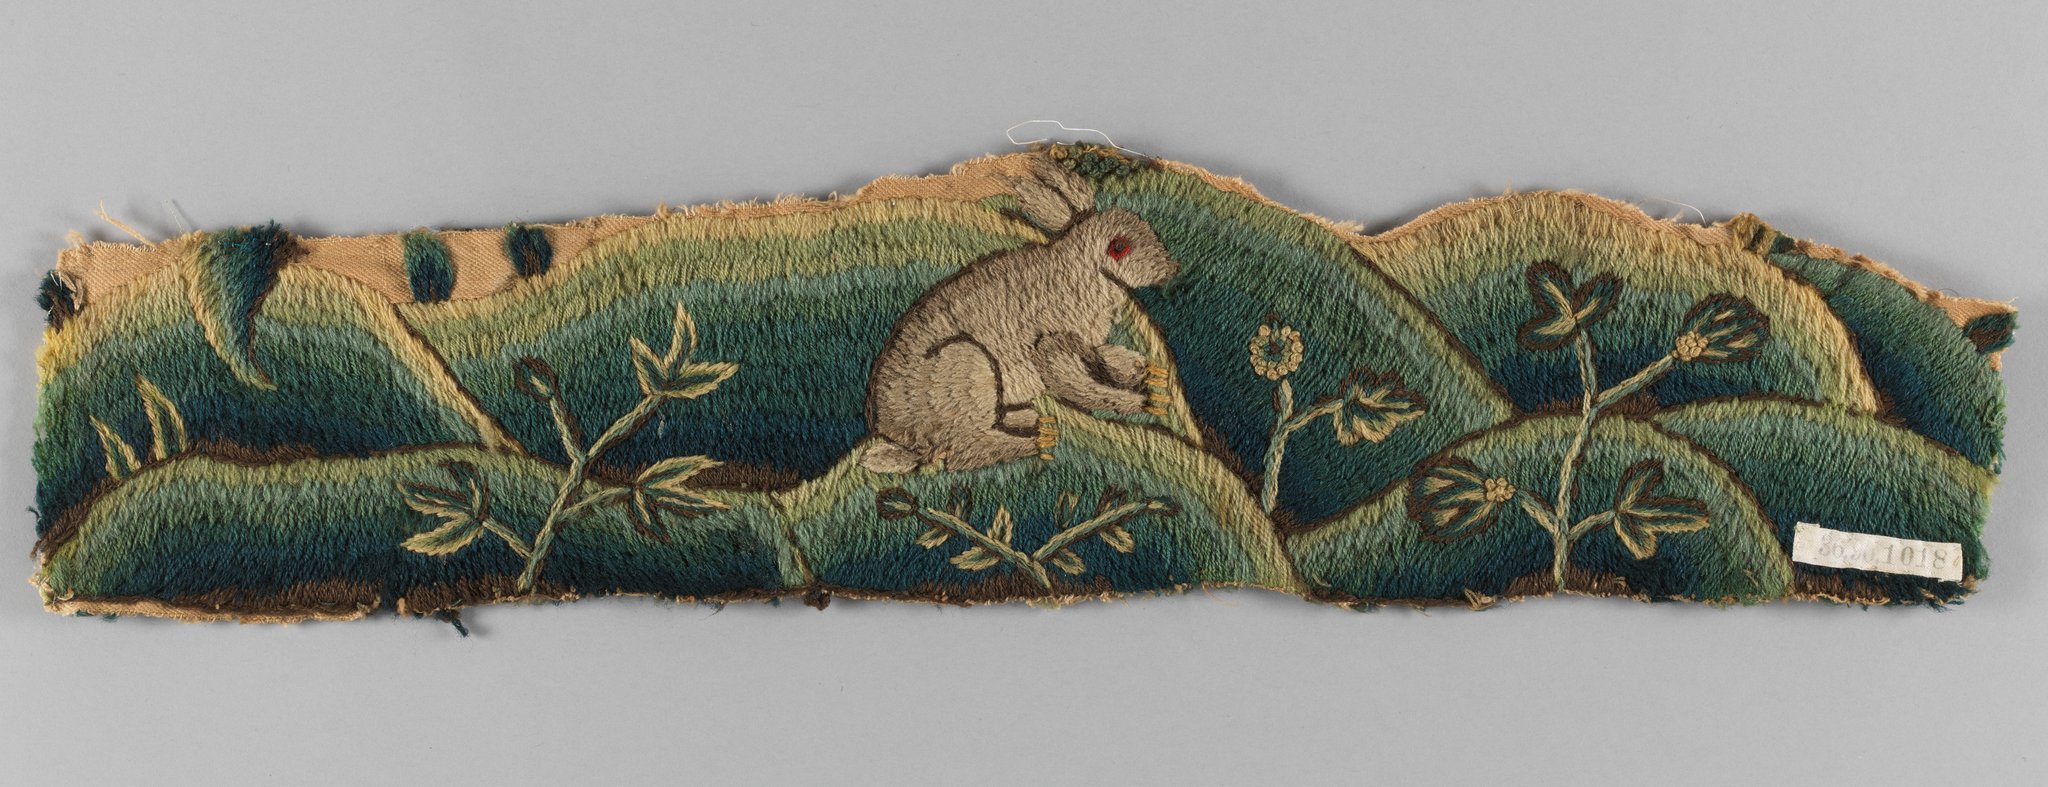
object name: piece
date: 1701-1800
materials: cotton, wool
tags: rabbits